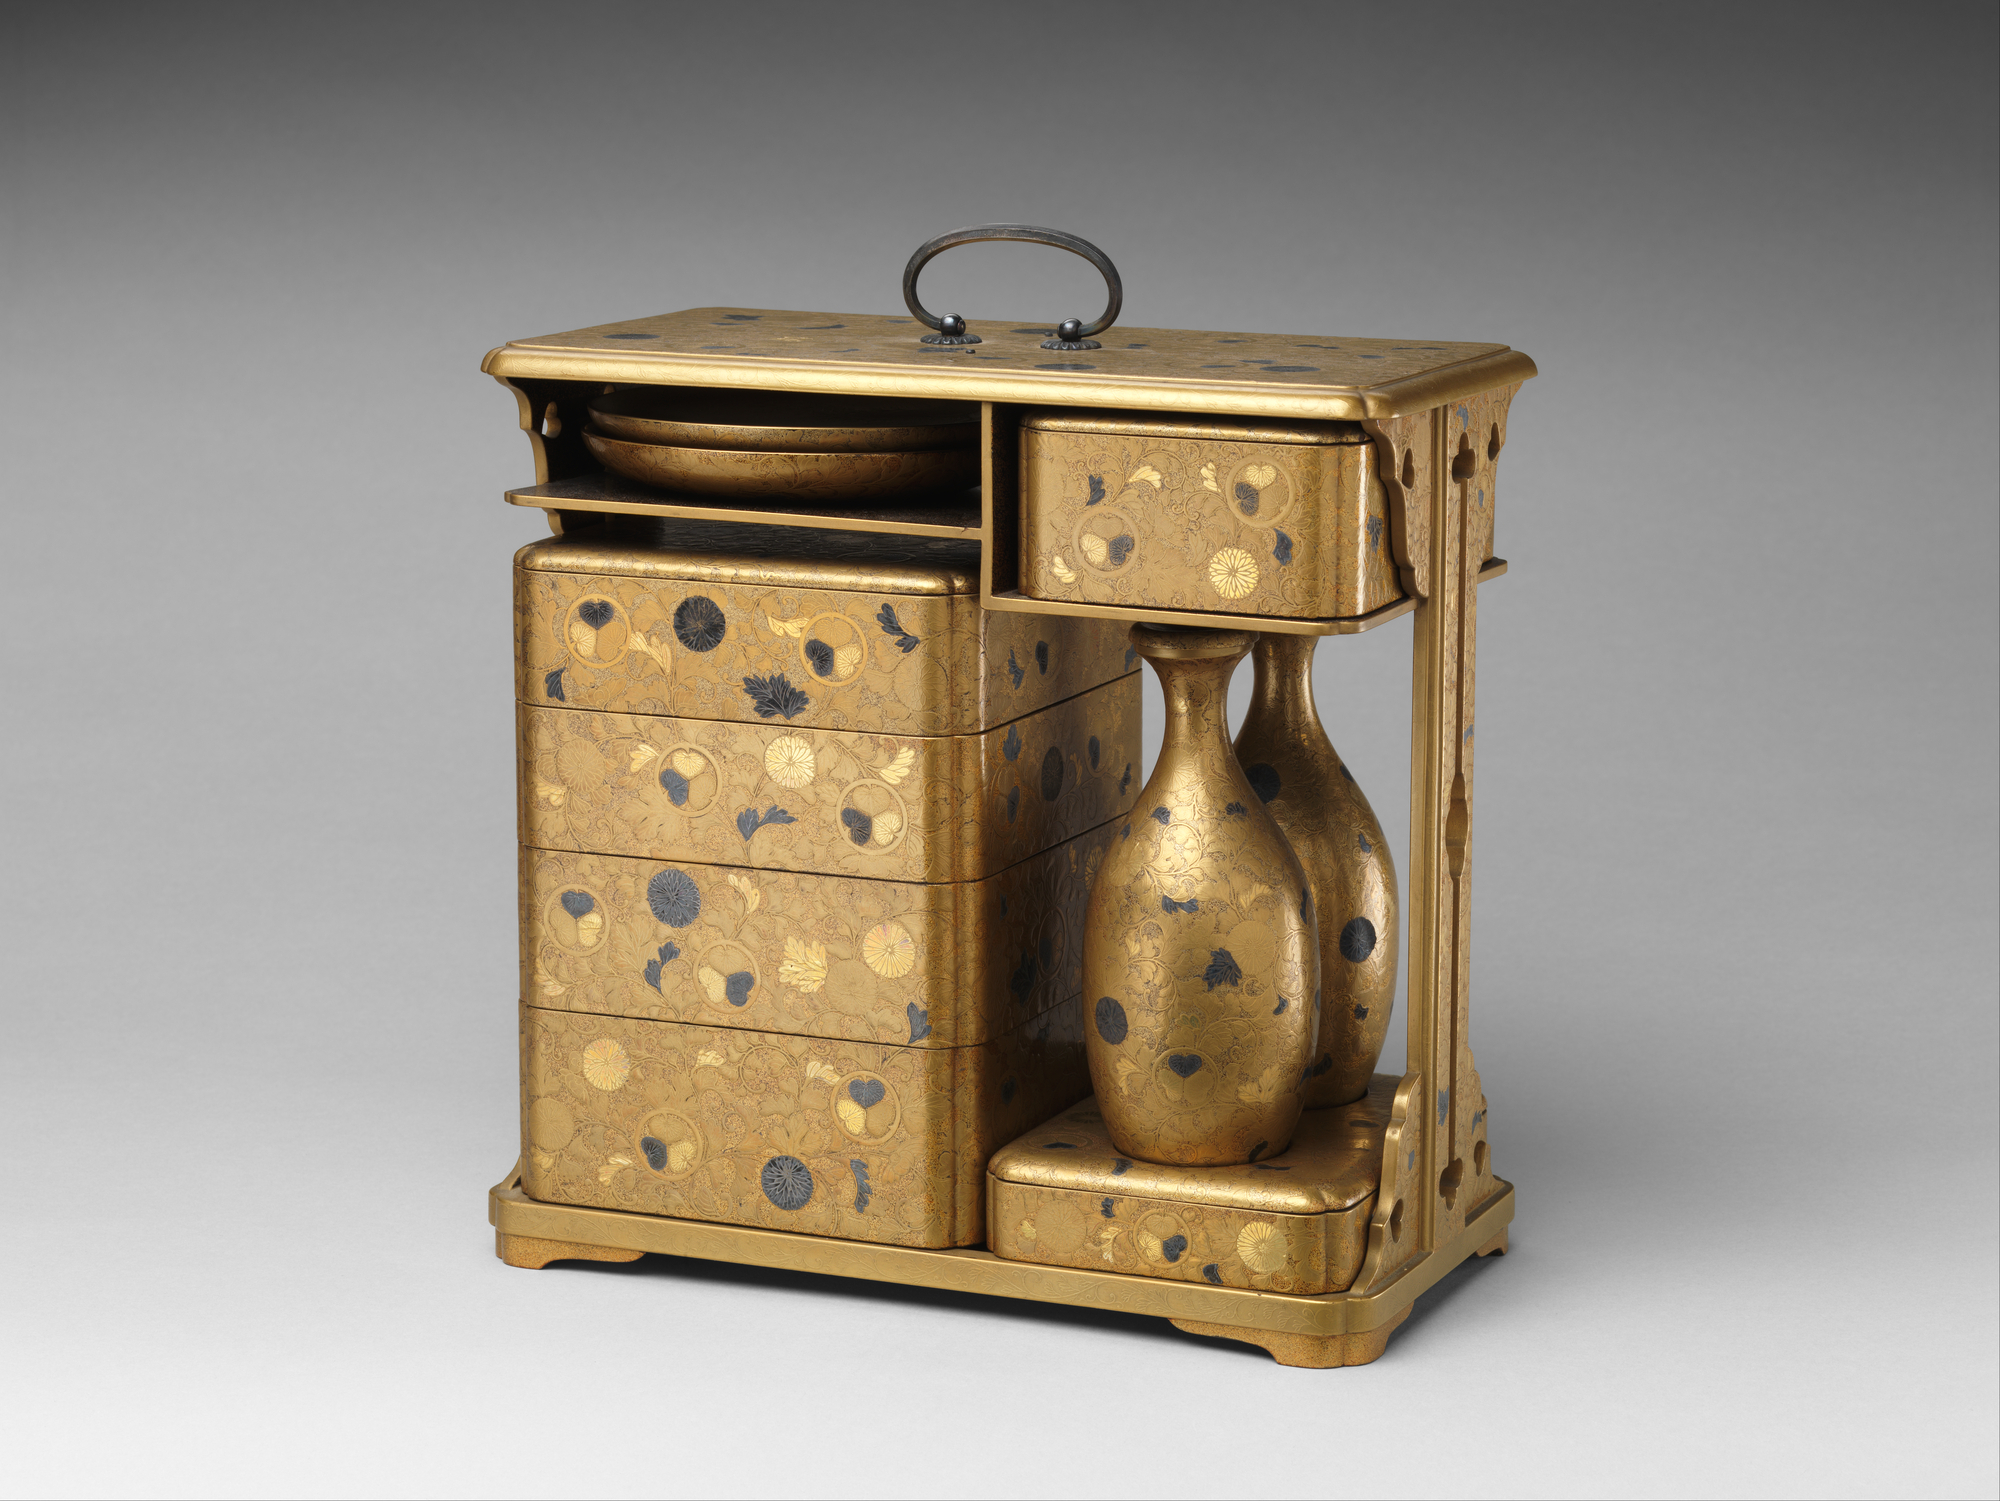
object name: picnic set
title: Portable Picnic Set (sagejū) with Chrysanthemums, Foliage Scroll, and Tokugawa Family Crest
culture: japanese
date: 1701-1800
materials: foil, gold, lacquer, silver, wood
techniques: hiramakie, lacquer